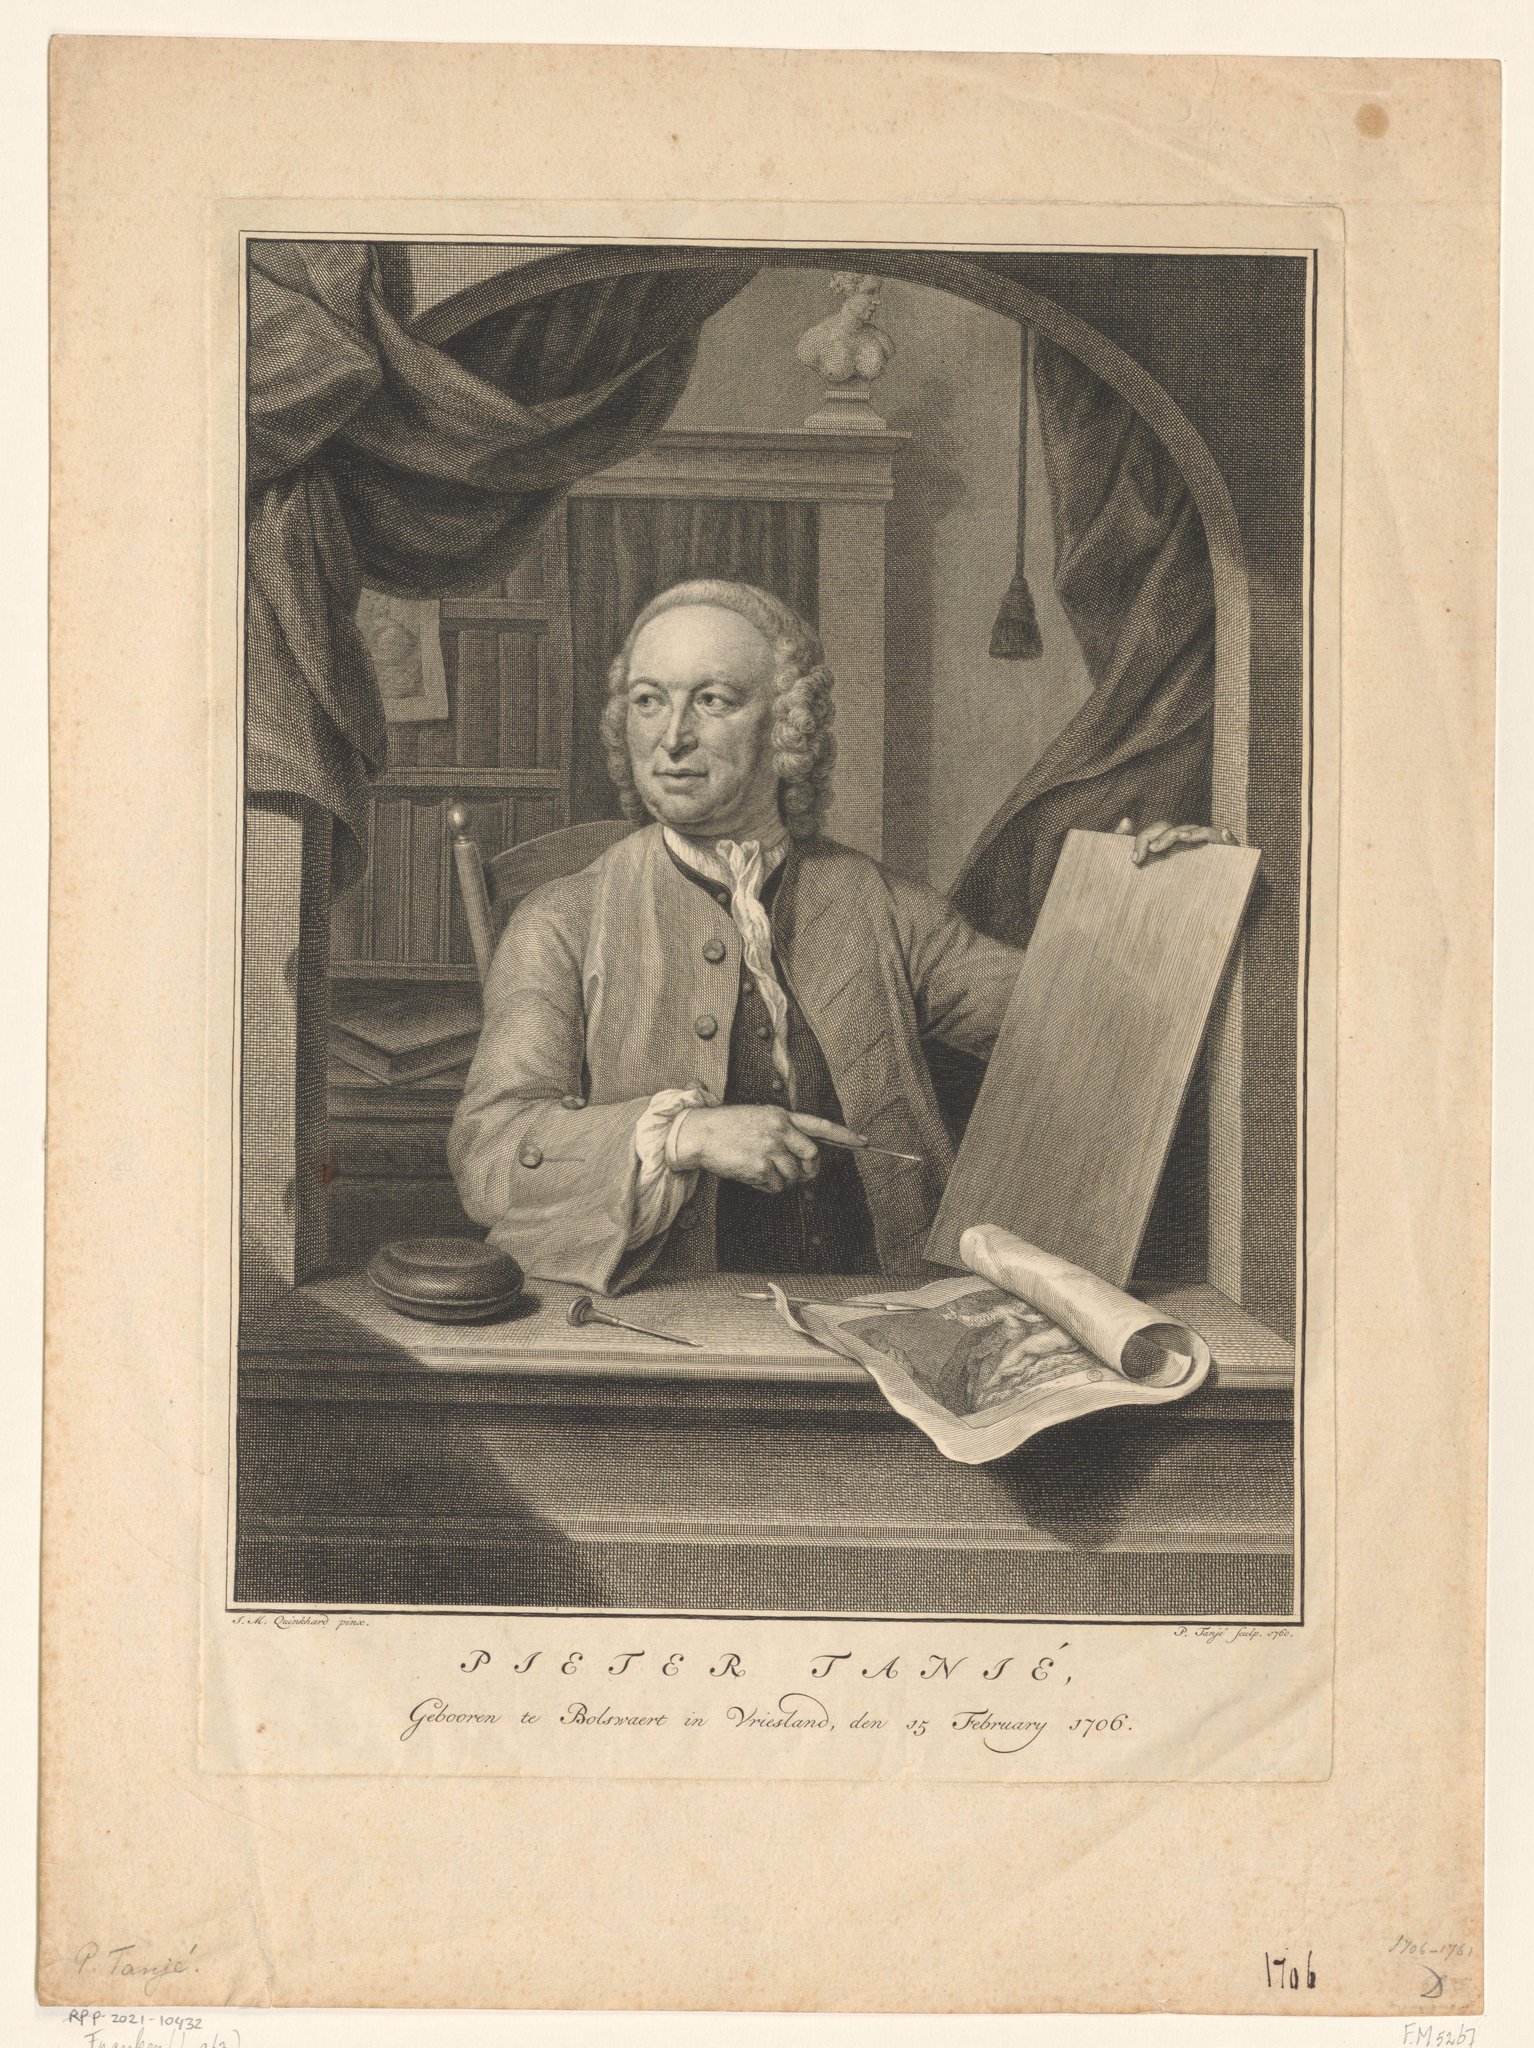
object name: print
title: Portret van Pieter Tanjé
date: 1760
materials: paper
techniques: engraving, etching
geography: amsterdam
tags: print maker, draughtsman, pieter tanjé, engraver, etcher, adult man, historical persons, portrait, self-portrait of graphic artist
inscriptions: collector's mark: Lugt 963, collector's mark: Lugt 2228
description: Portret van prentmaker Pieter Tanjé, zittend in een boogvormige nis achter een vensterbank, met burijn en koperplaat in de handen. Op de vensterbank liggen een prent, burijnen en een tampon. Achter hem een vertrek met boekenkast.